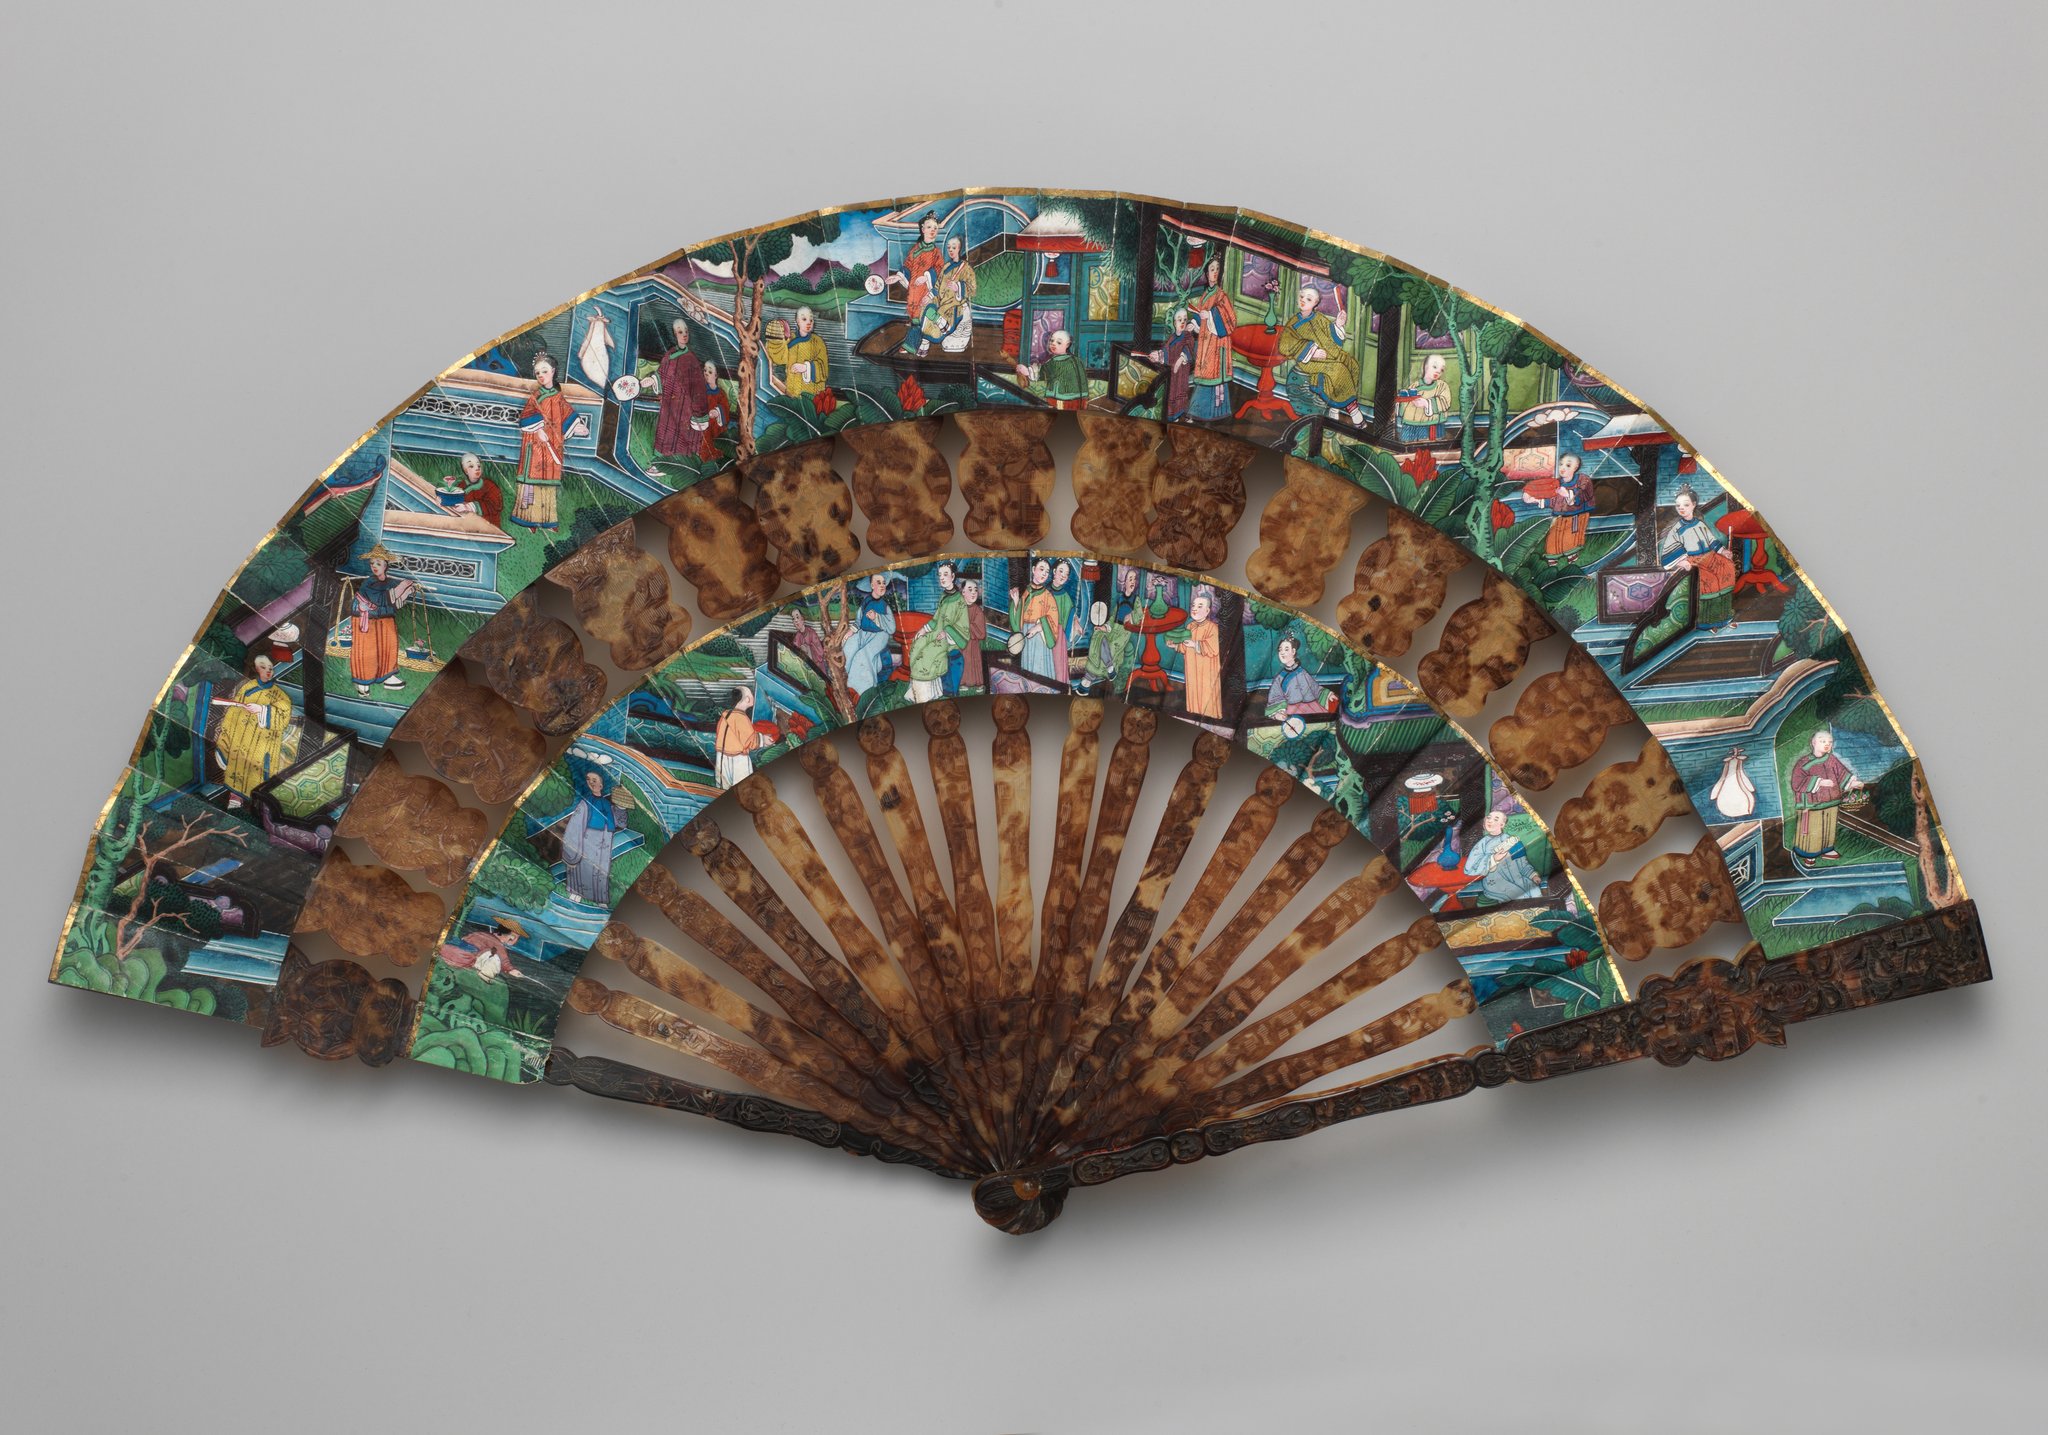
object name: fan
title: Folding Fan with Multiple Scenes of Figures in Courtyard Gardens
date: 1801-1900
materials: paper, shell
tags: men,women,landscapes